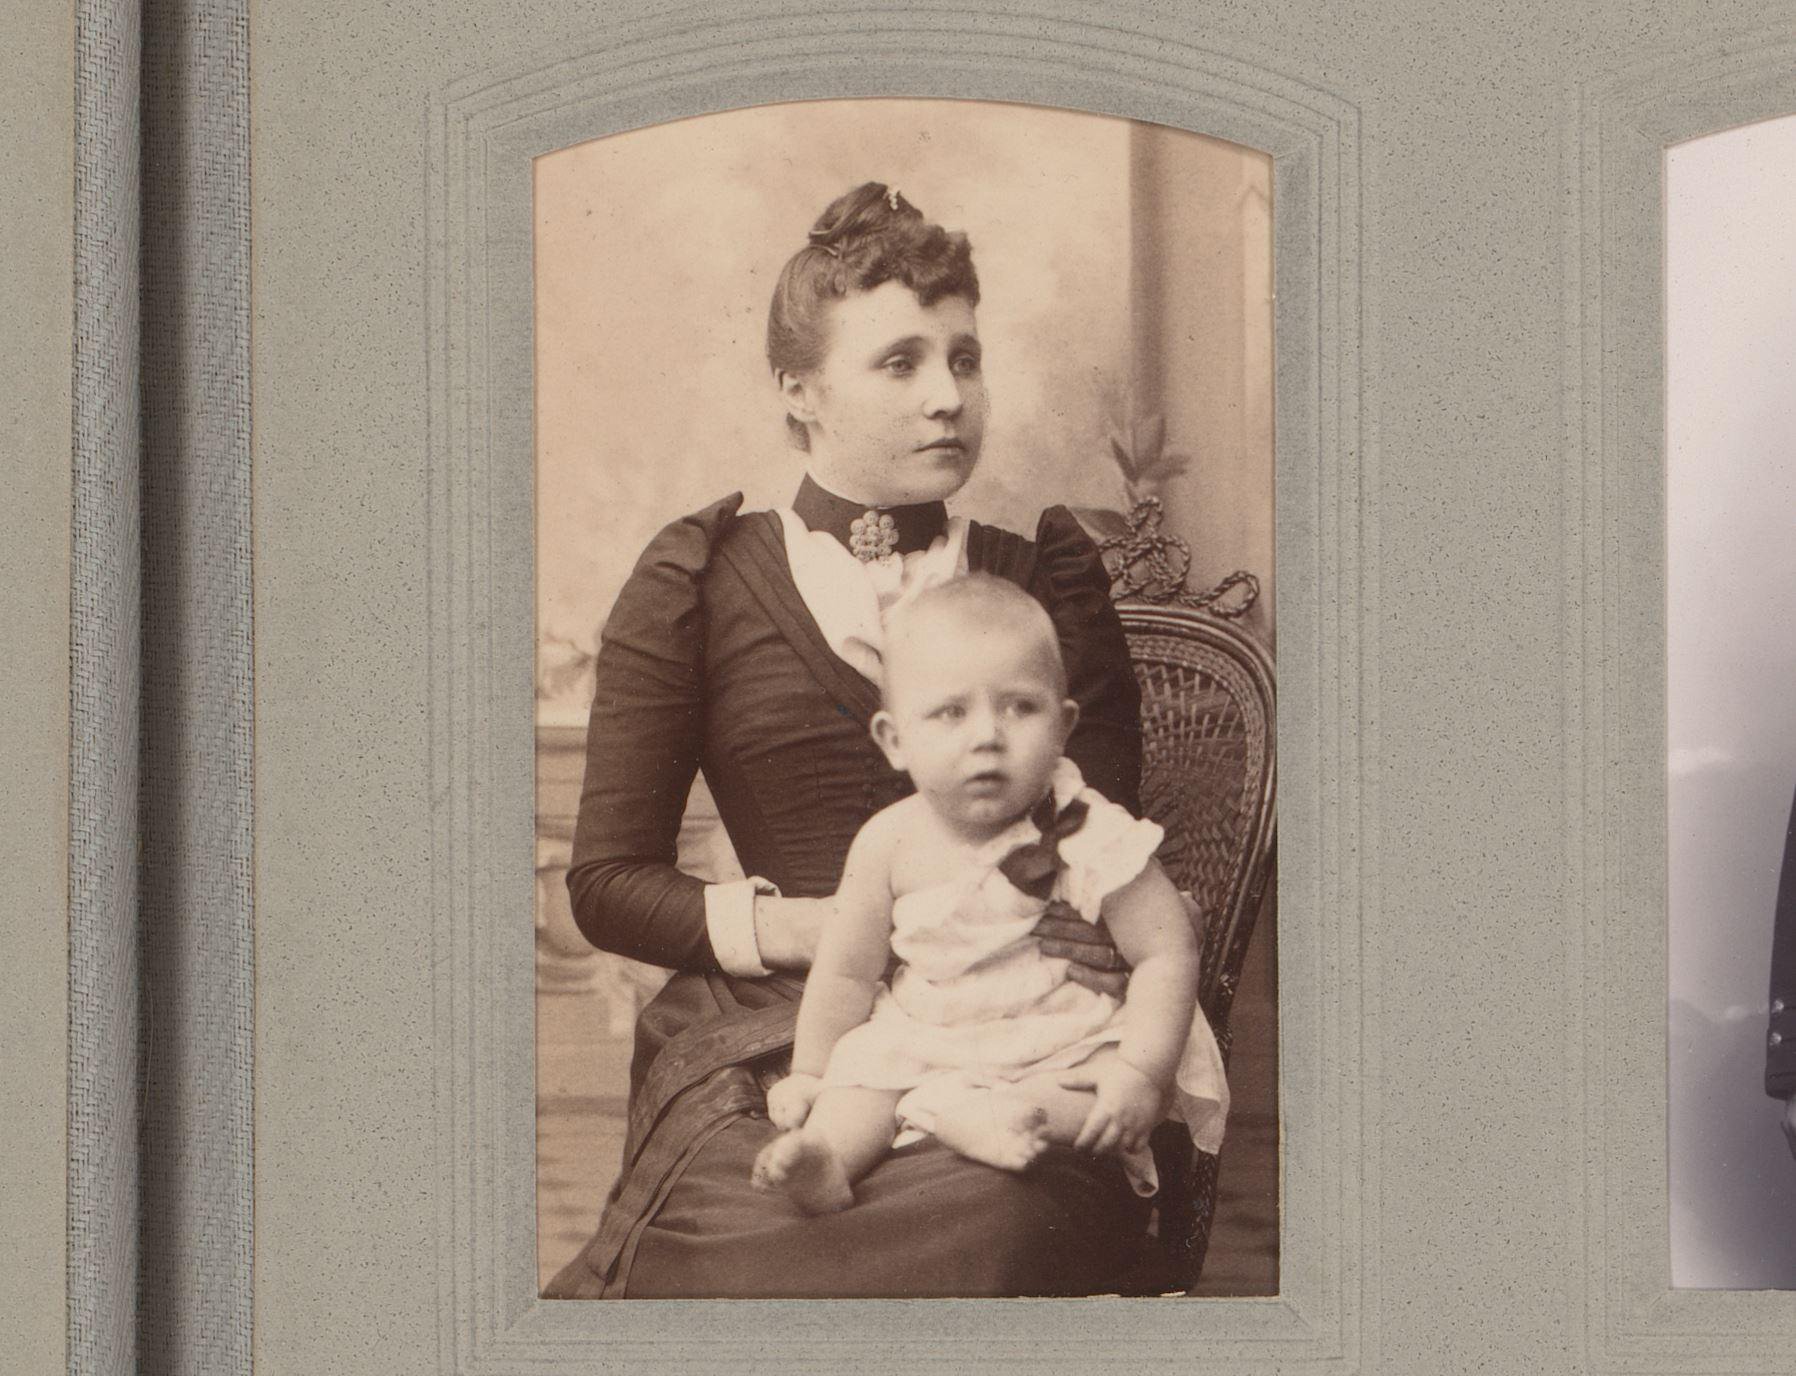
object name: album leaf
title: Portret van een zittende vrouw met een baby op schoot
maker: sophie andersson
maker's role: fotograaf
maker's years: 1851-1912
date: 1860-1900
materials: cardboard, photographic support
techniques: albumen print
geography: stockholm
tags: sitting figure - aa - female human figure, historical persons - bb - woman, infant, baby ~ the ages of man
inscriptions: inscription: ‘S. Andersson/ Stockholm/ Barnhusgatan No. 6./ Filial: DALARÖ.’